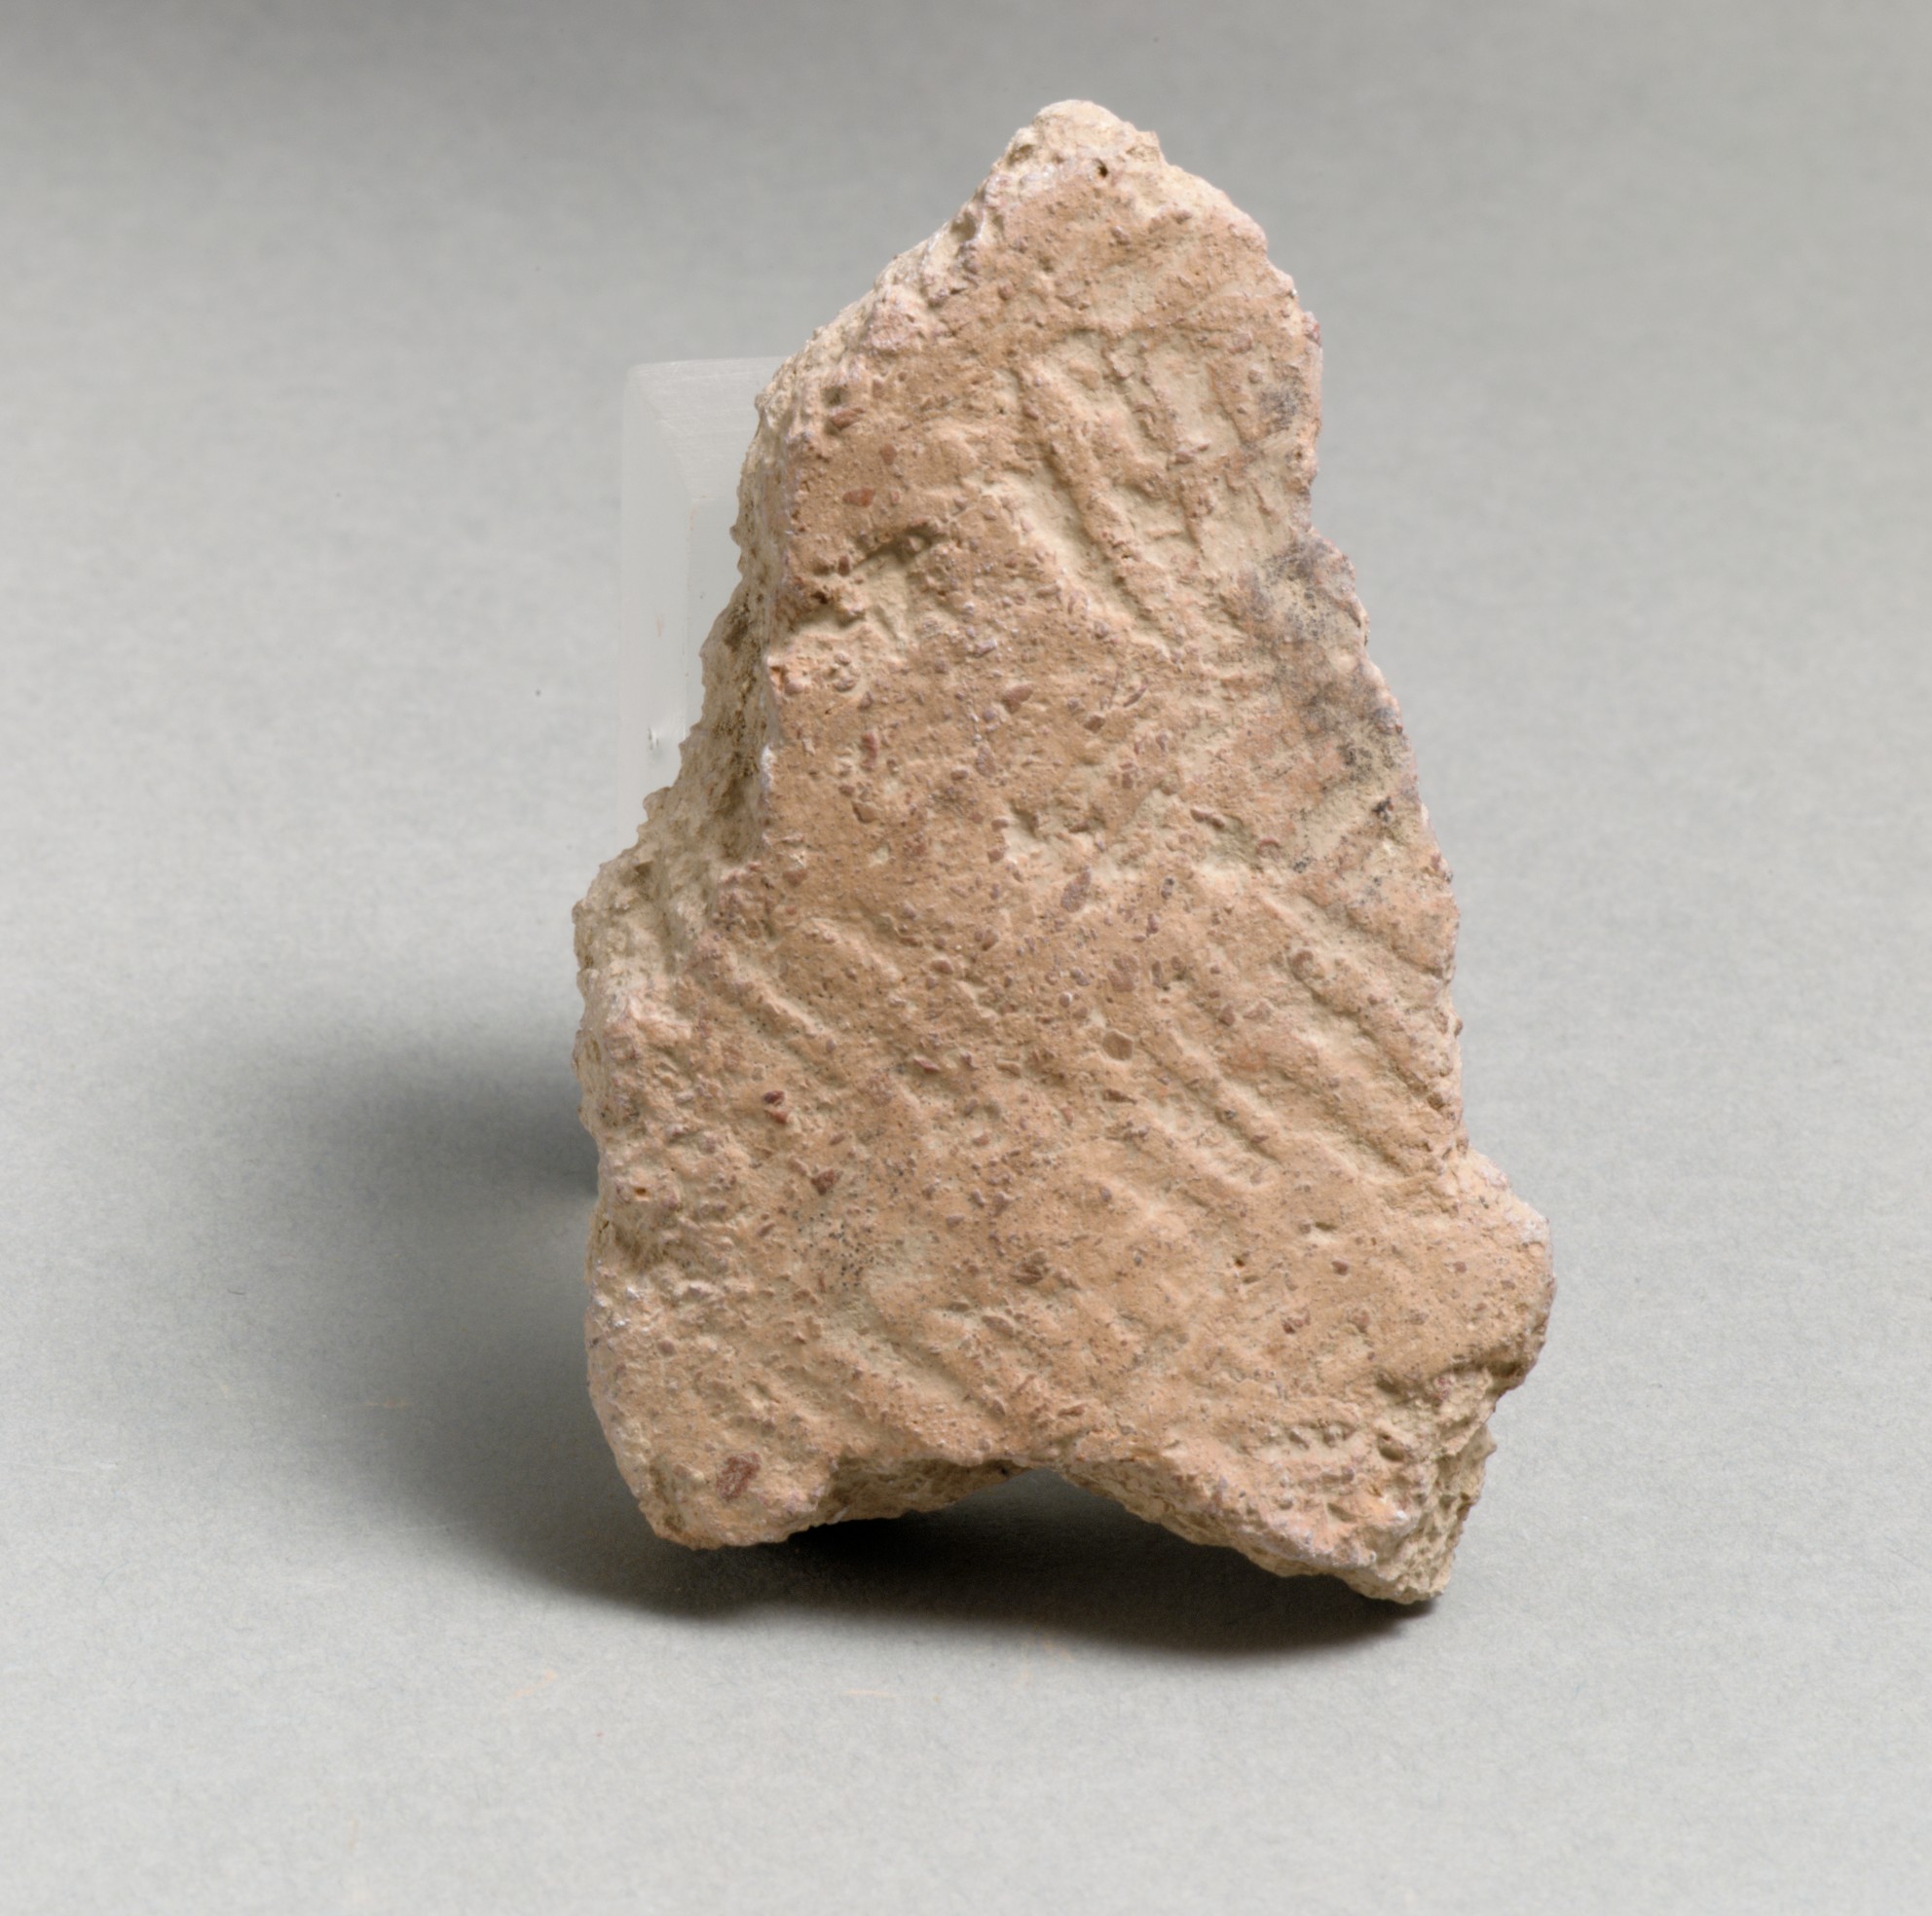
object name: vase fragment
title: Terracotta fragment of a pithos (?) with impressed zigzag pattern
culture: helladic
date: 2300-2100 BCE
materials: terracotta